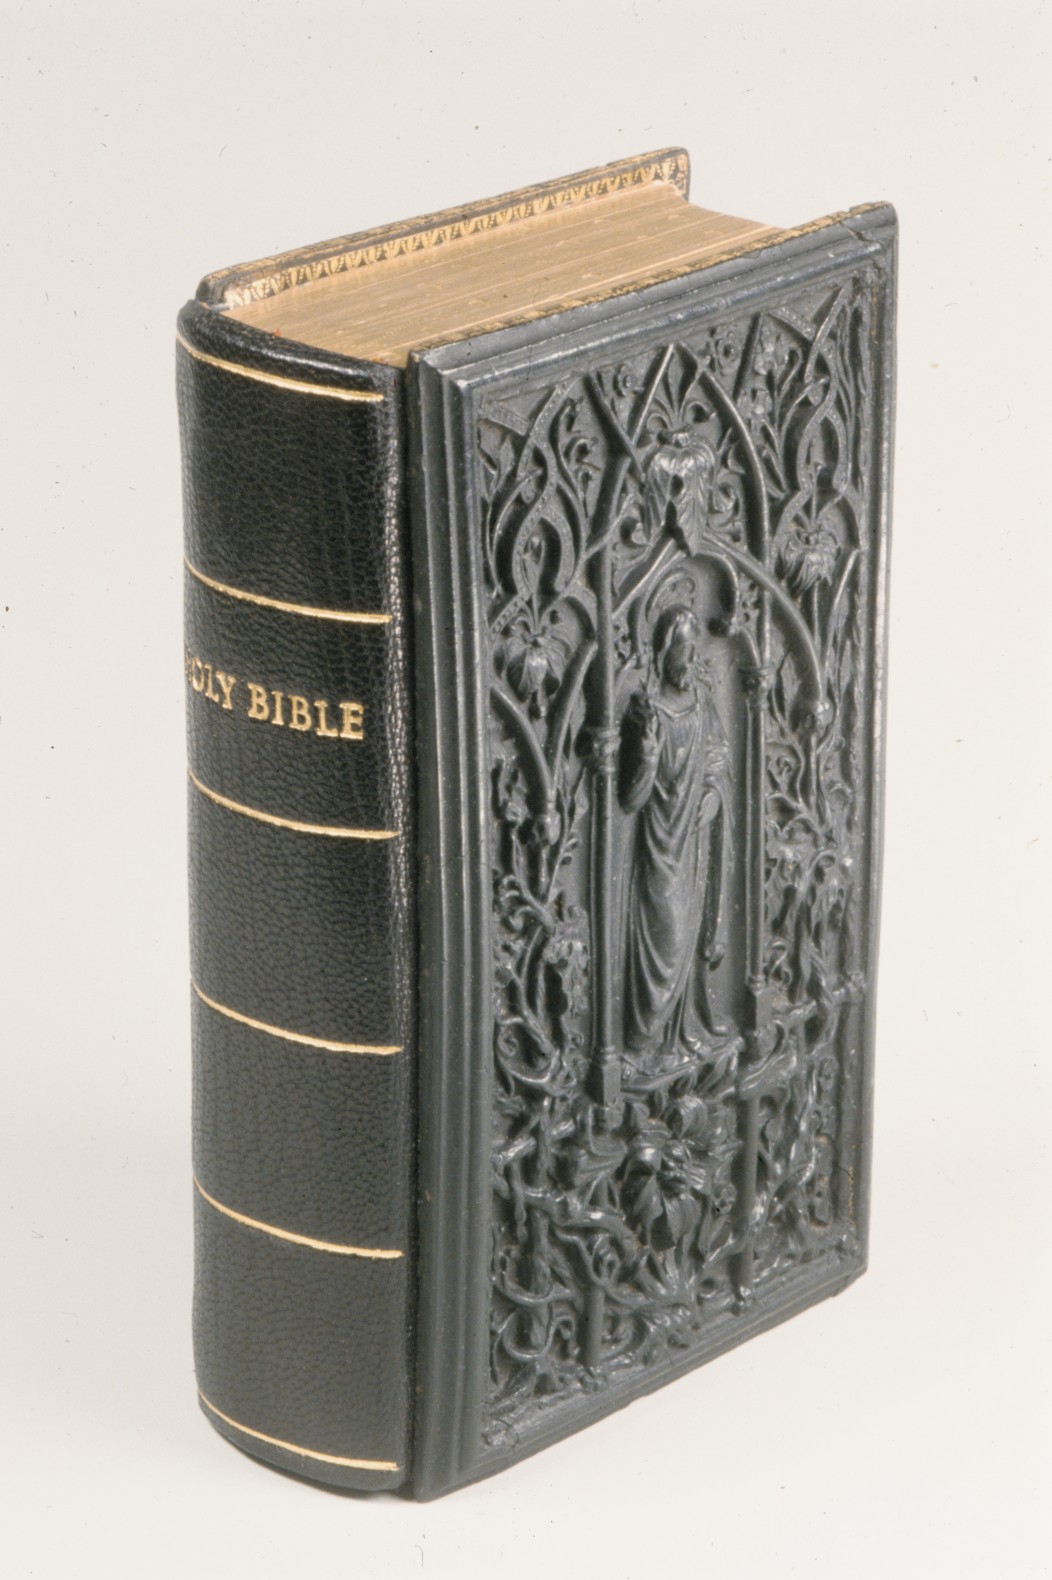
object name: bible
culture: british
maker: george edward eyre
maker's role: maker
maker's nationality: british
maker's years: 1818-1887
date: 1847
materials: paper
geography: england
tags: christ